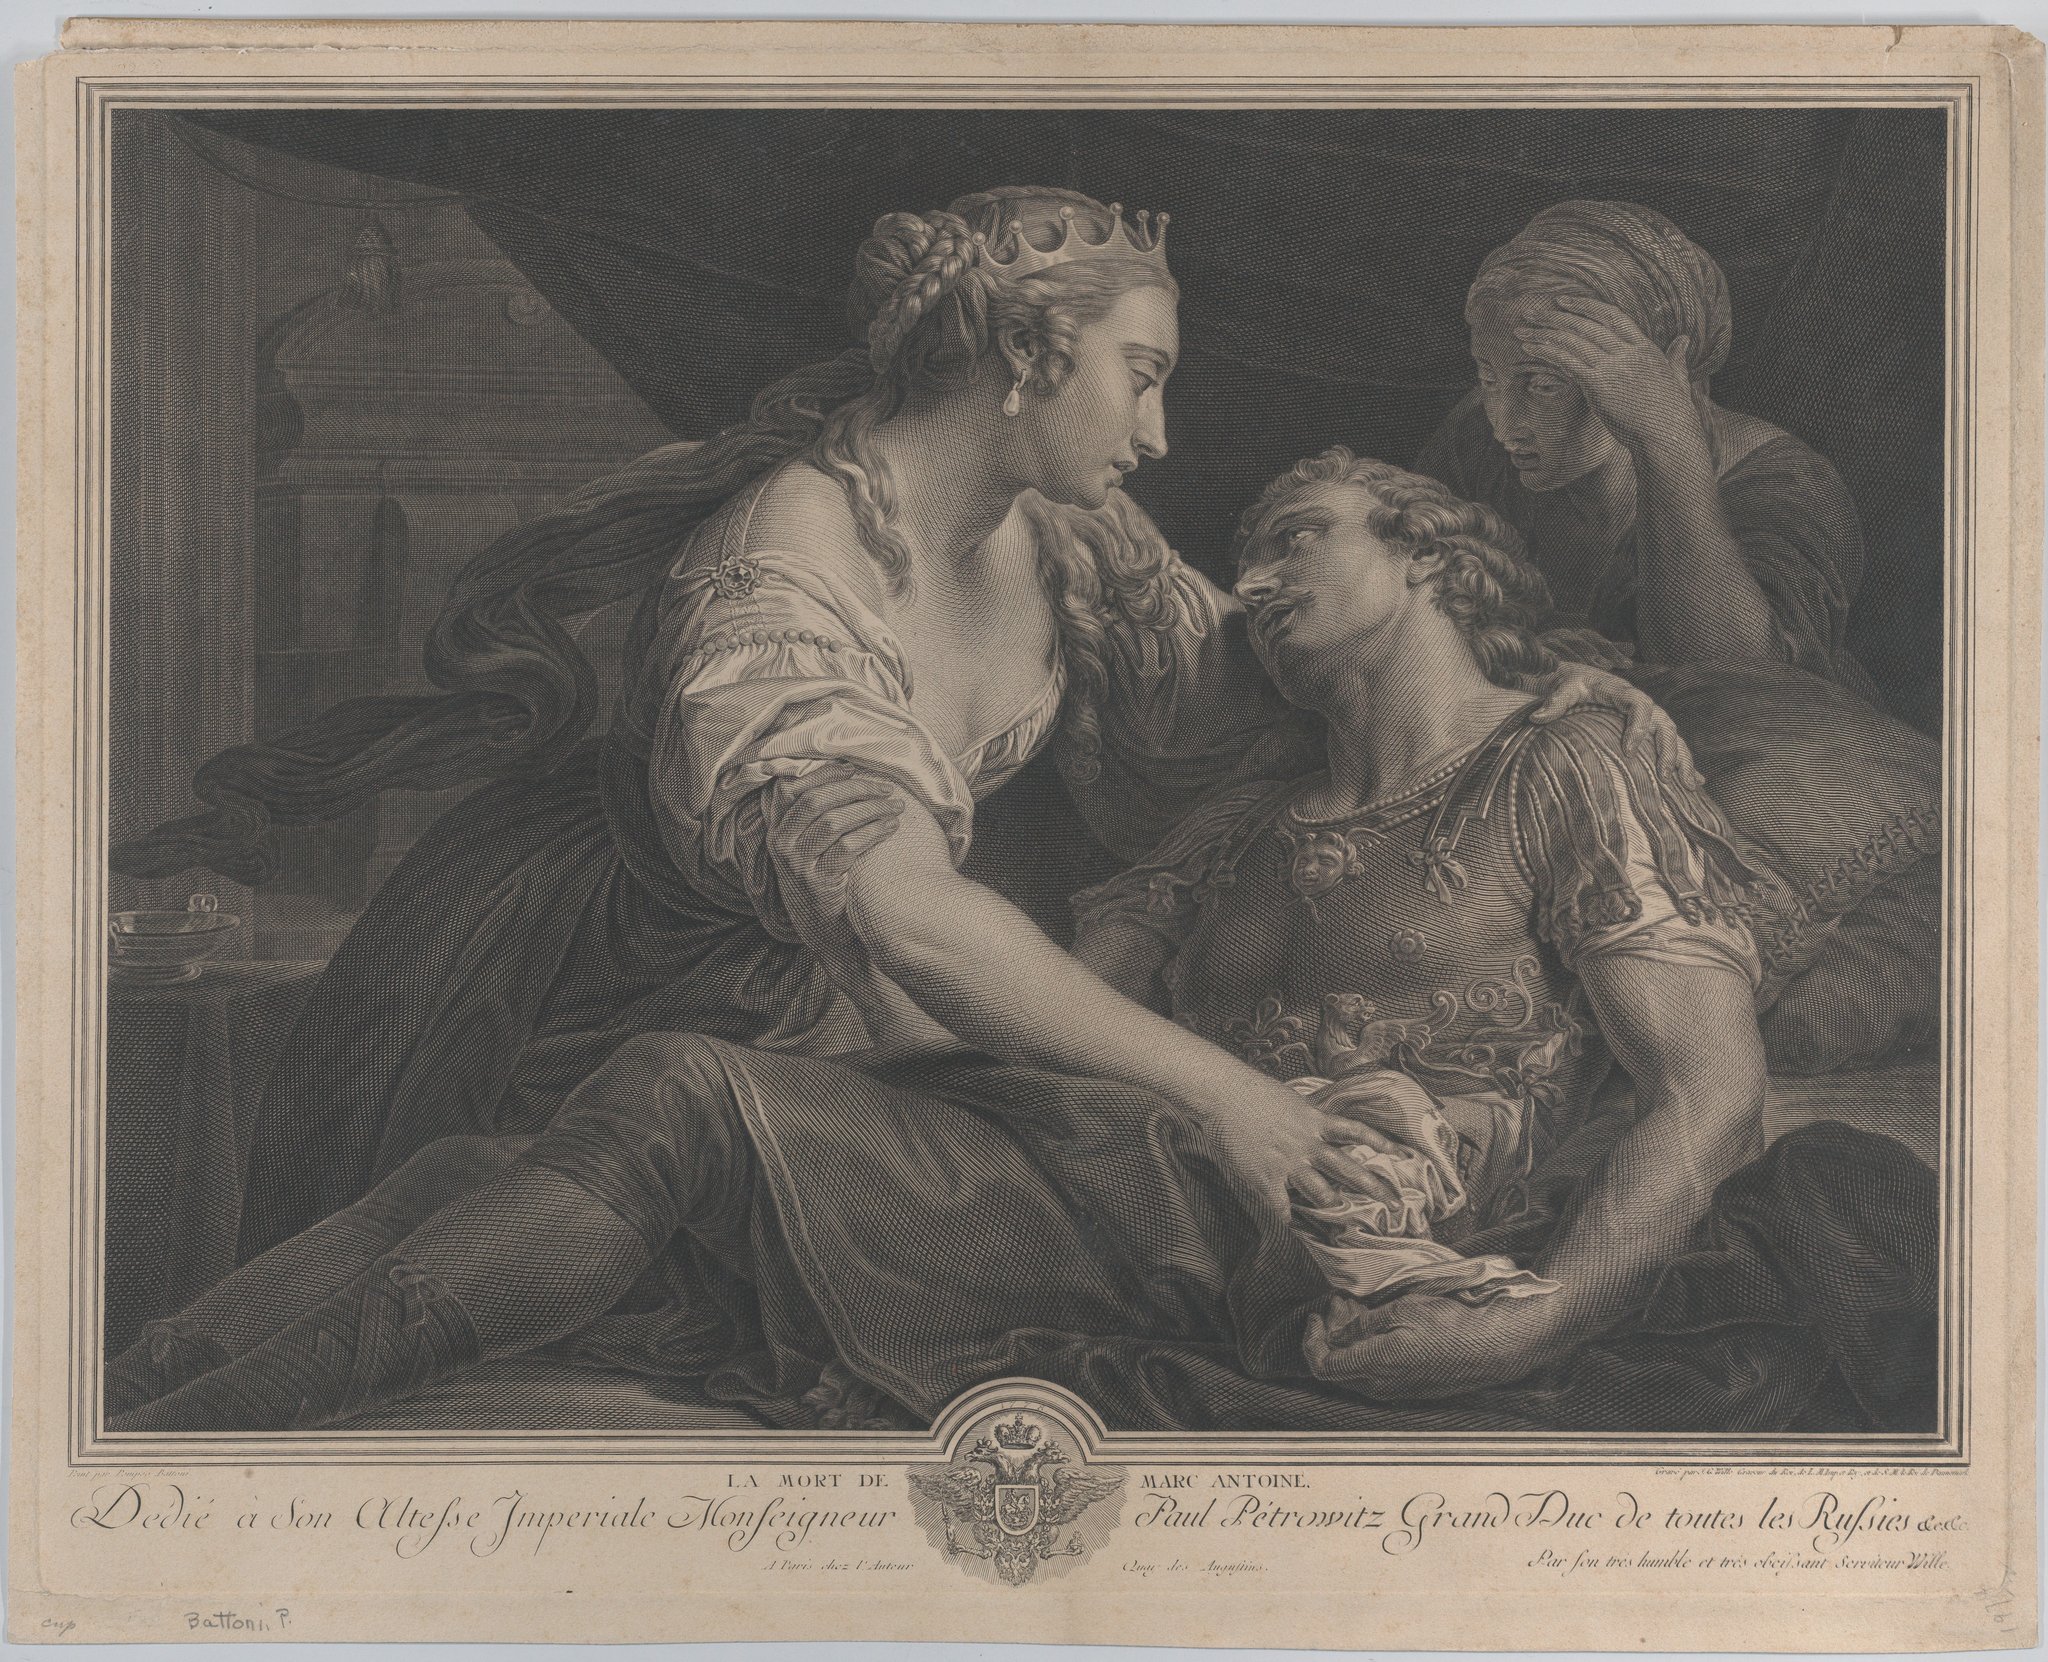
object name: print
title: The Death of Mark Antony with Cleopatra at left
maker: johann georg wille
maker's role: artist and publisher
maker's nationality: german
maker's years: 1715-1808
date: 1778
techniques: engraving